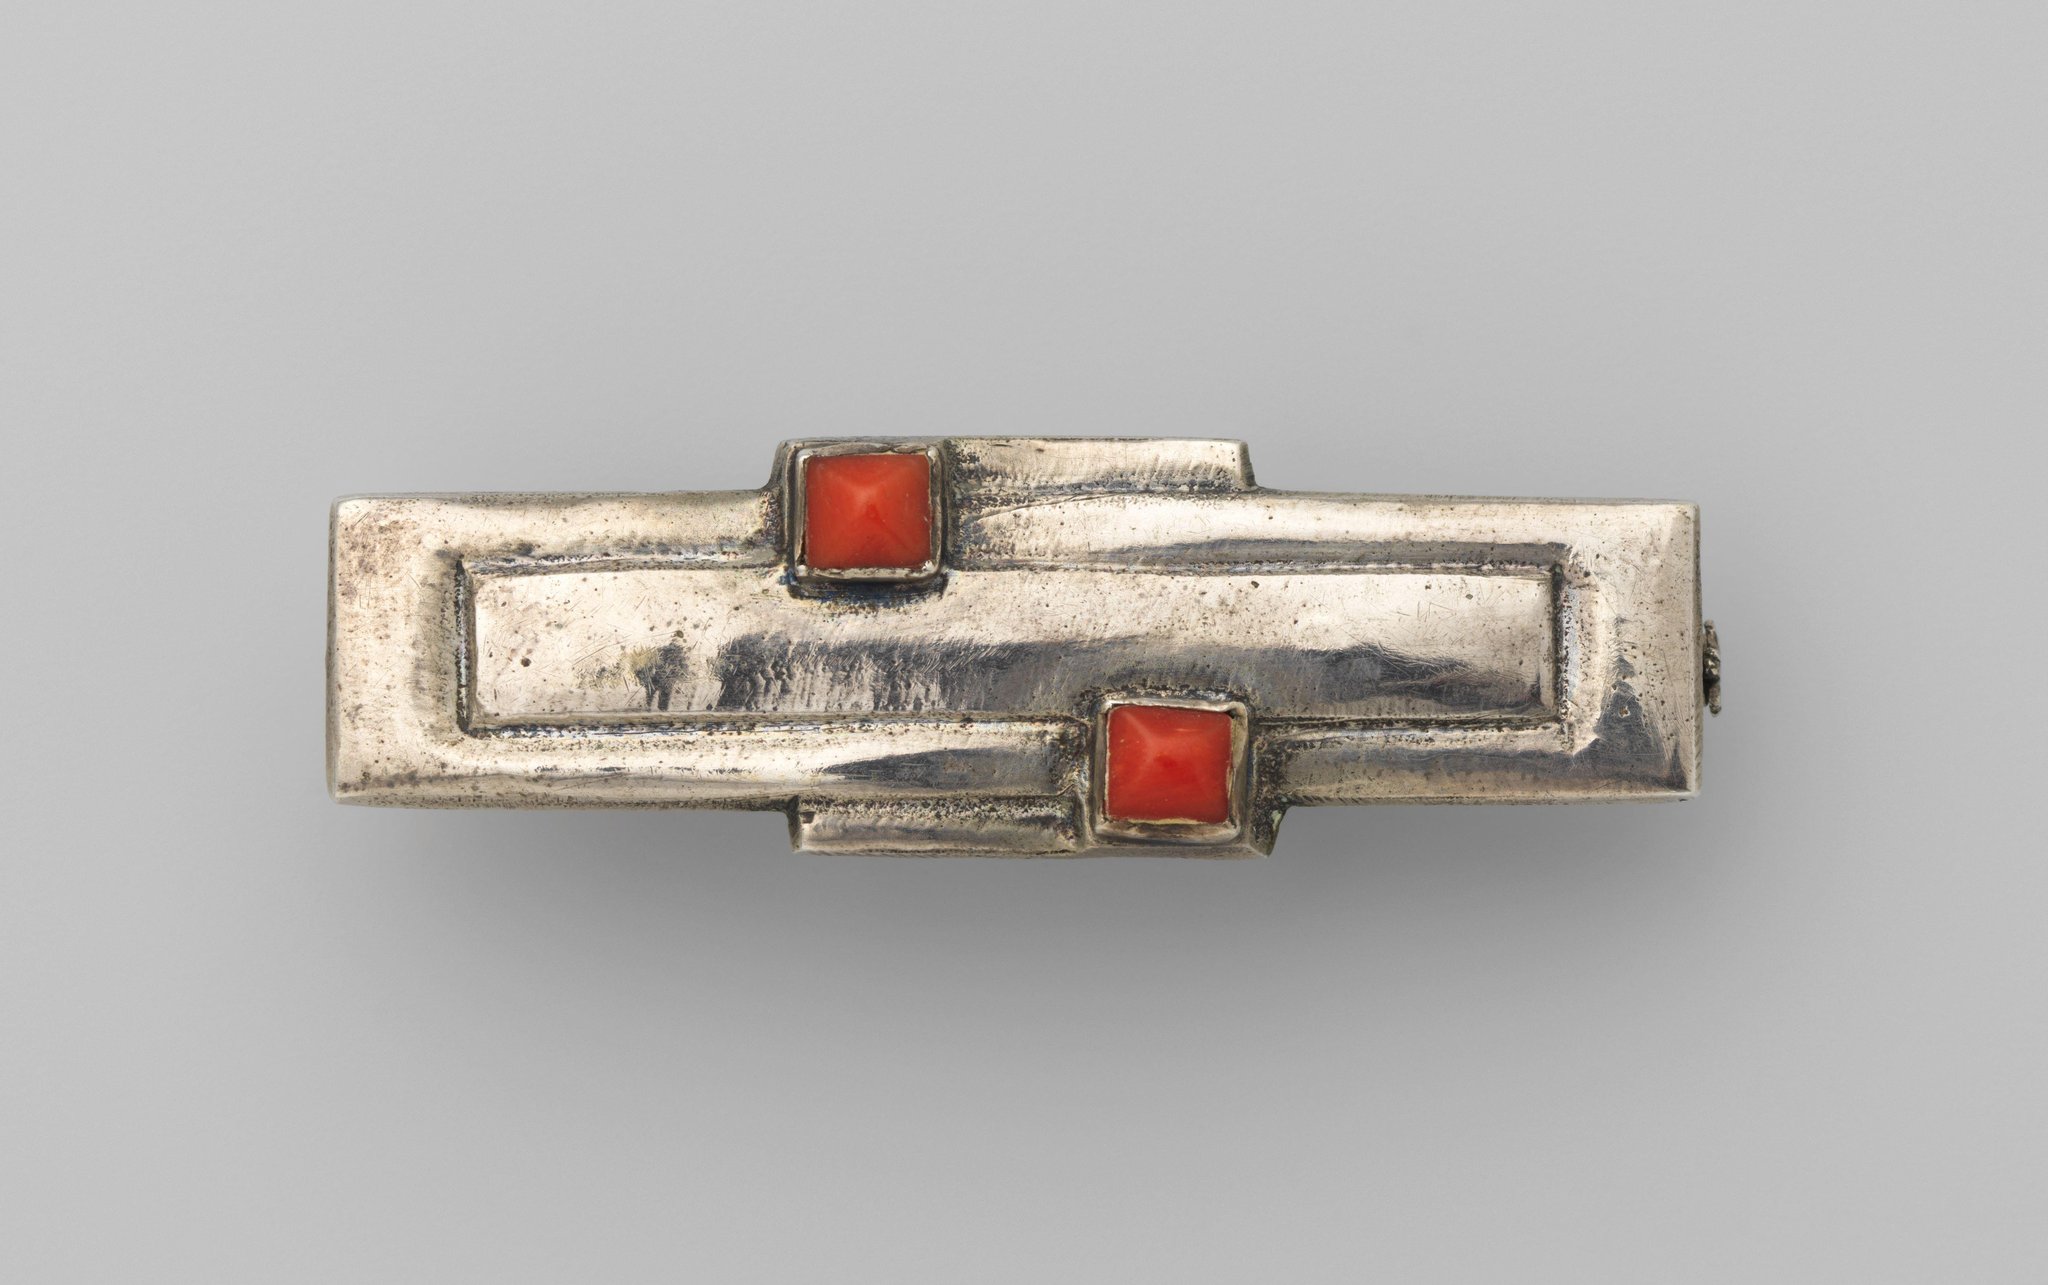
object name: brooch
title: Brochette van zilver en bloedkoraal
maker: Anonymous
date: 1930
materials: coral, silver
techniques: faceting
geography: netherlands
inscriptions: maker's mark: ‘J6C’, alloy mark, : ‘V’, maker's mark: ‘WW’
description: Brochette met twee carré gefacetteeerde bloedkoralen voorzien van een kanonsluiting.